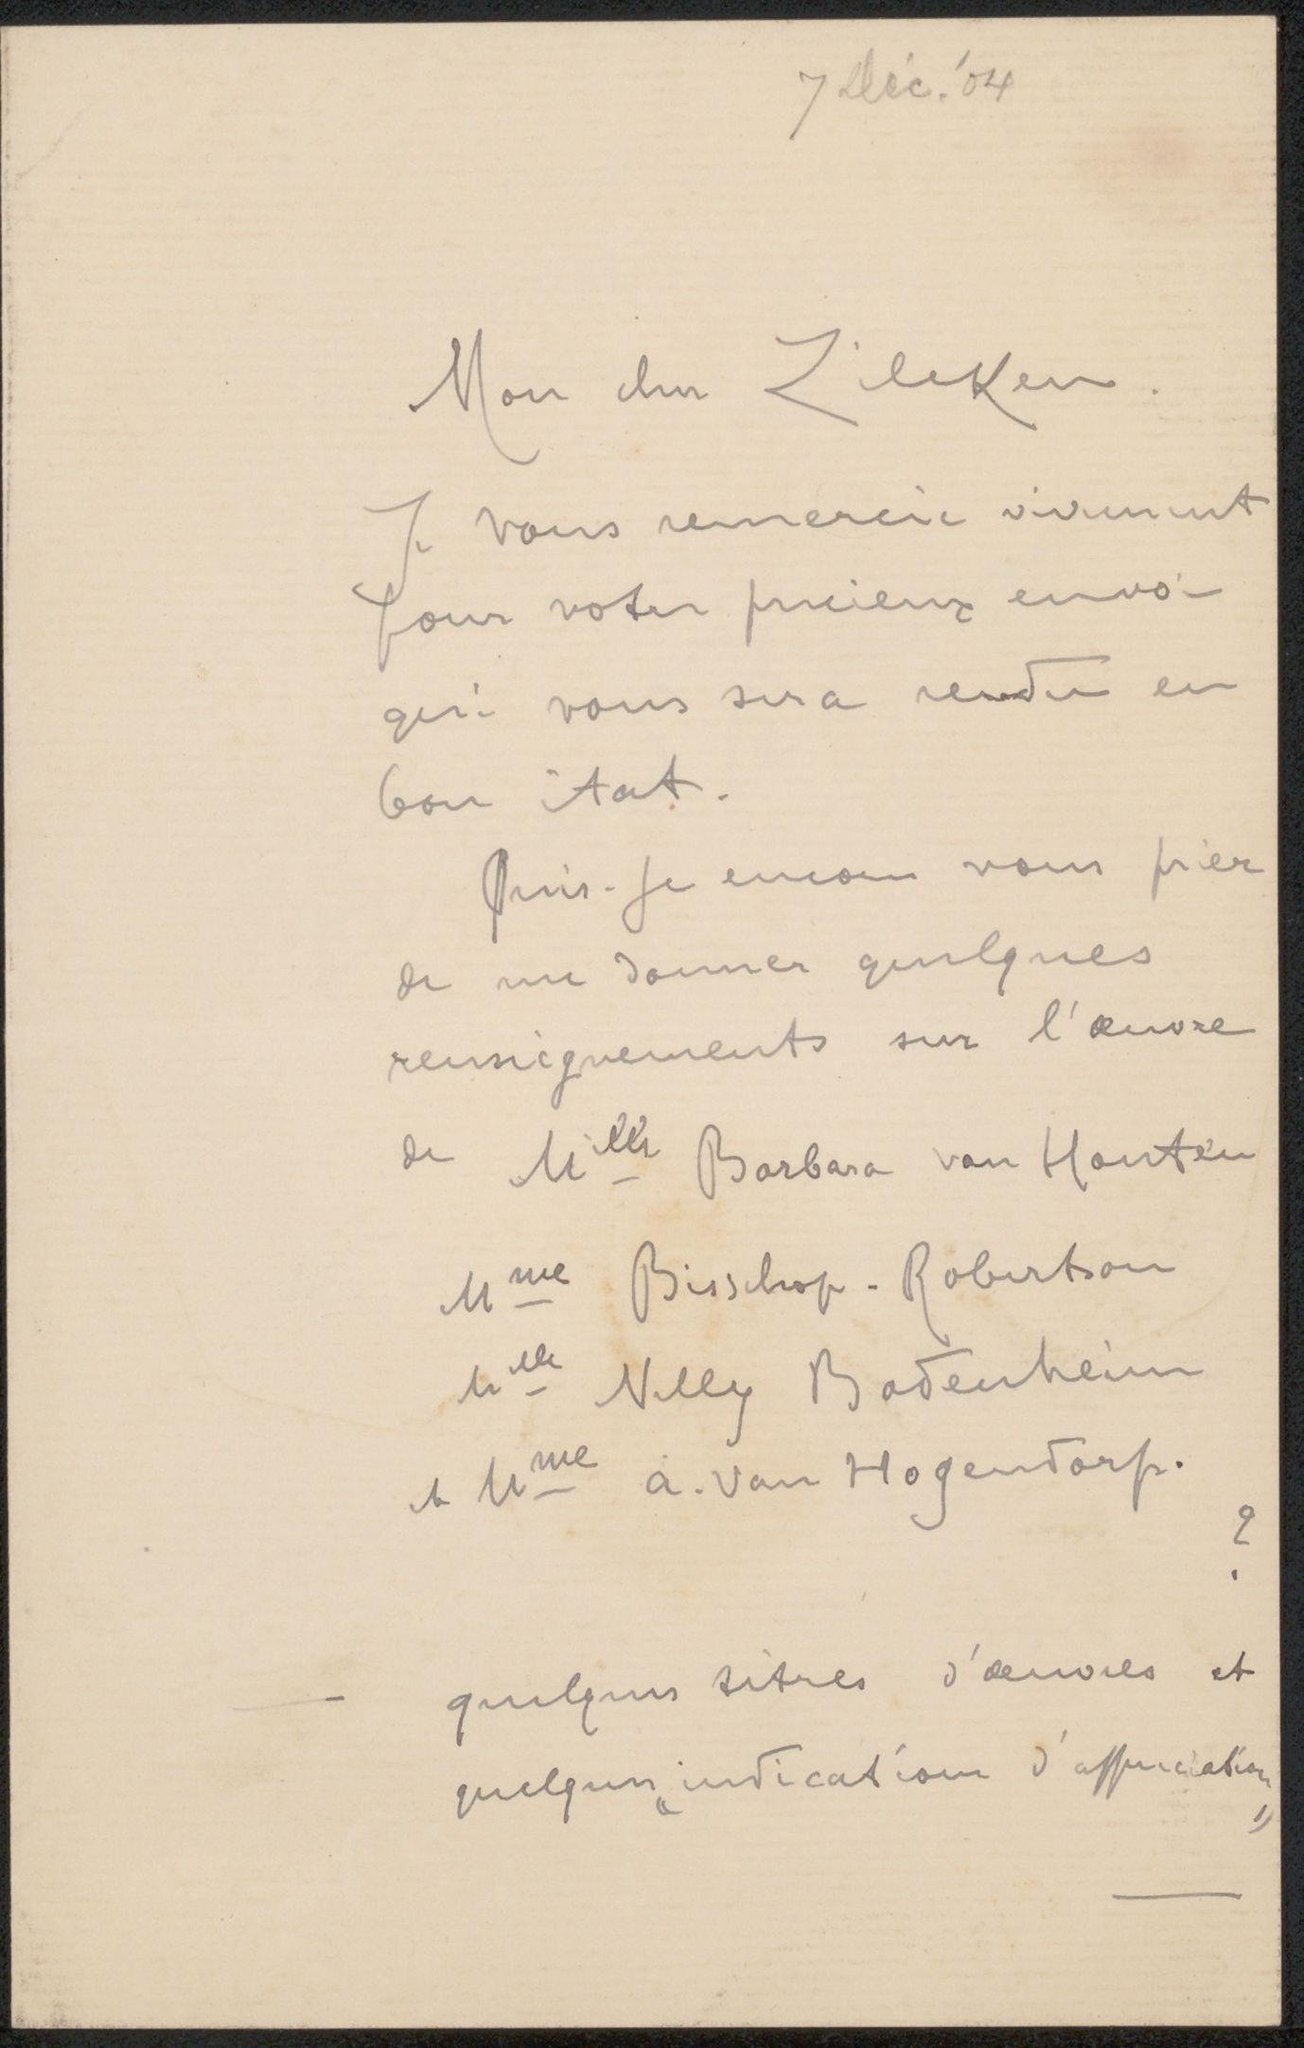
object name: letter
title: Brief aan Philip Zilcken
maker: fernand khnopff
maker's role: draughtsman, print maker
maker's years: 1858-1921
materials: ink, paper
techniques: pen, writing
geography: brussels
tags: amsterdam, print maker, draughtsman, designer, nelly bodenheim, barbara elisabeth van houten, suze robertson, batavia, adrienne jacqueline s' jacob, the hague, painter, philip zilcken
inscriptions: collector's mark: ‘RPK’, seal: ‘FK’